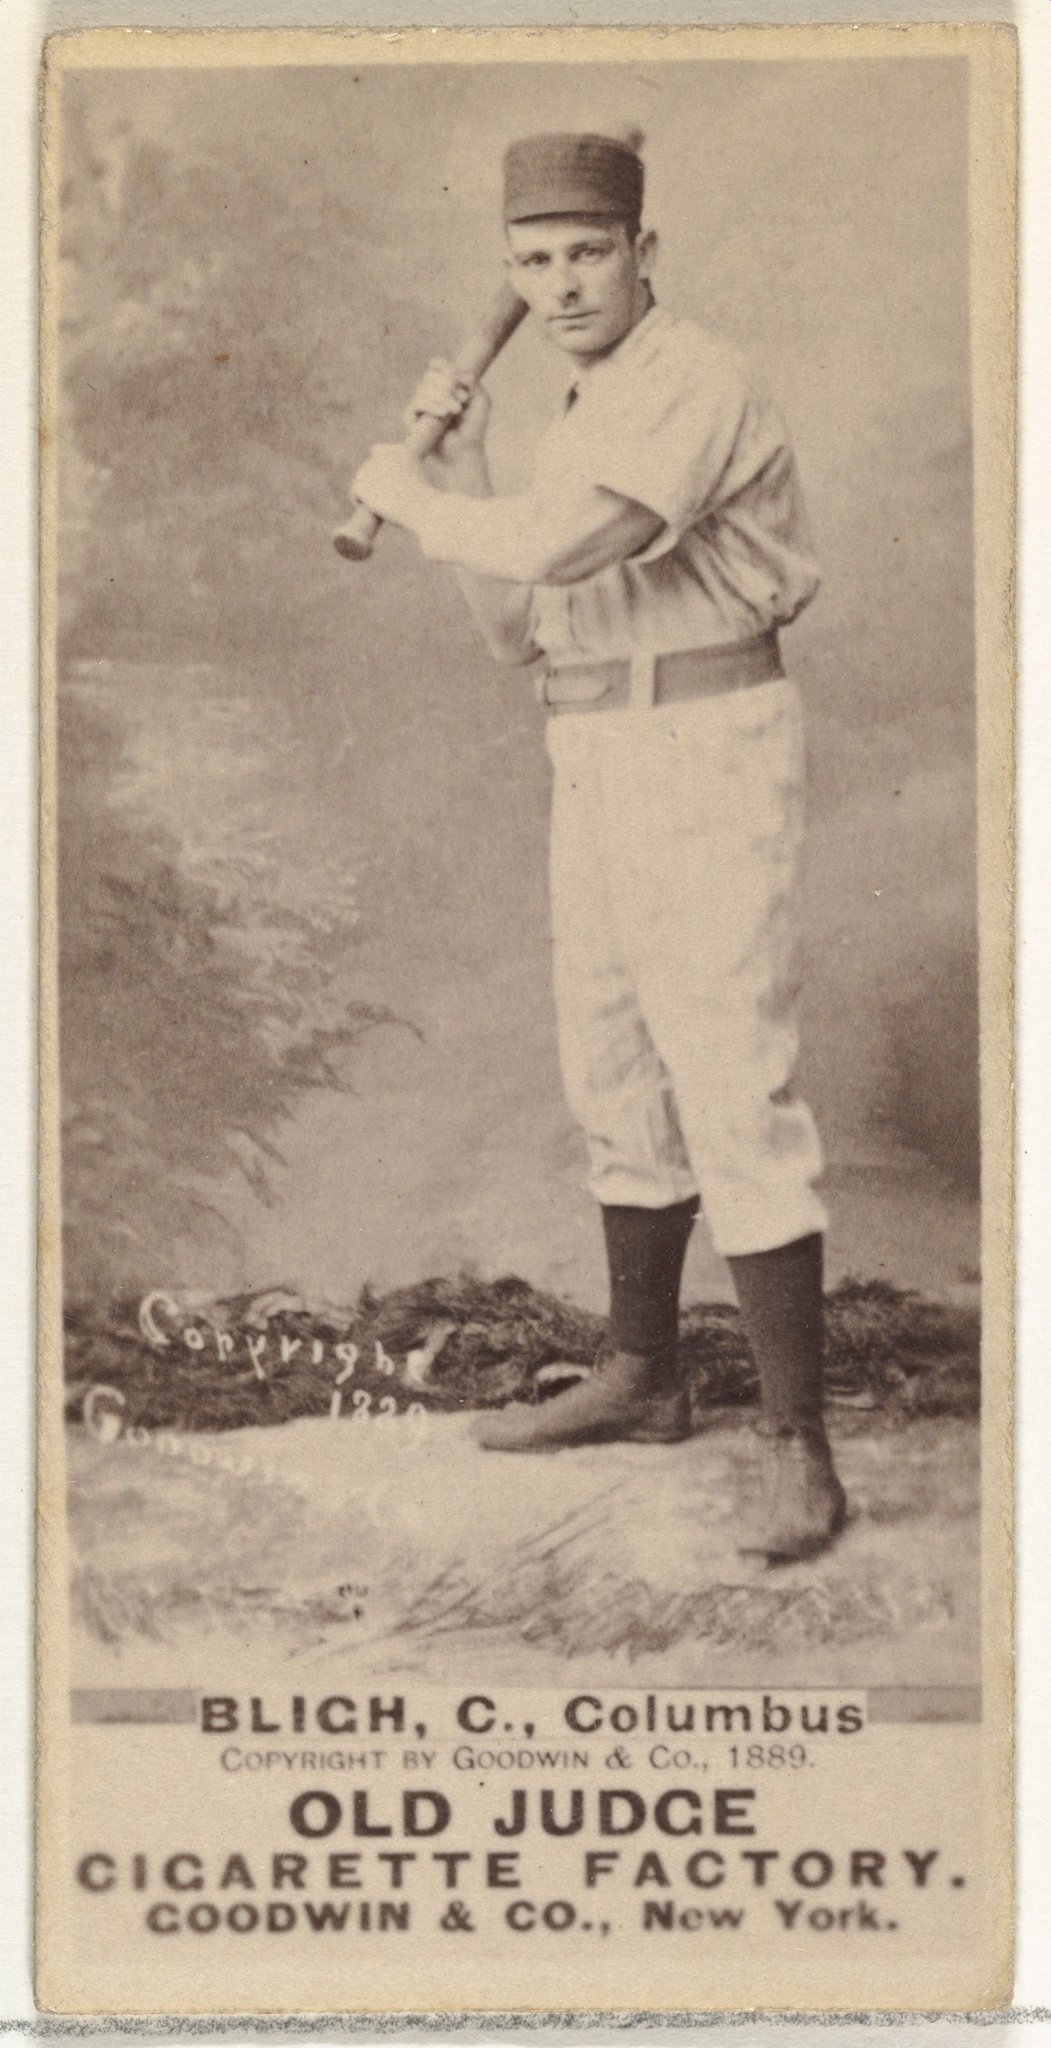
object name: baseball card, photograph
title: Edwin Forrest "Ned" Bligh, Catcher, Cleveland, from the Old Judge series (N172) for Old Judge Cigarettes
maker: goodwin & company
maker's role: publisher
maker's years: 1850-1950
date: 1889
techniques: albumen silver print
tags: men,portraits,baseball,athletes